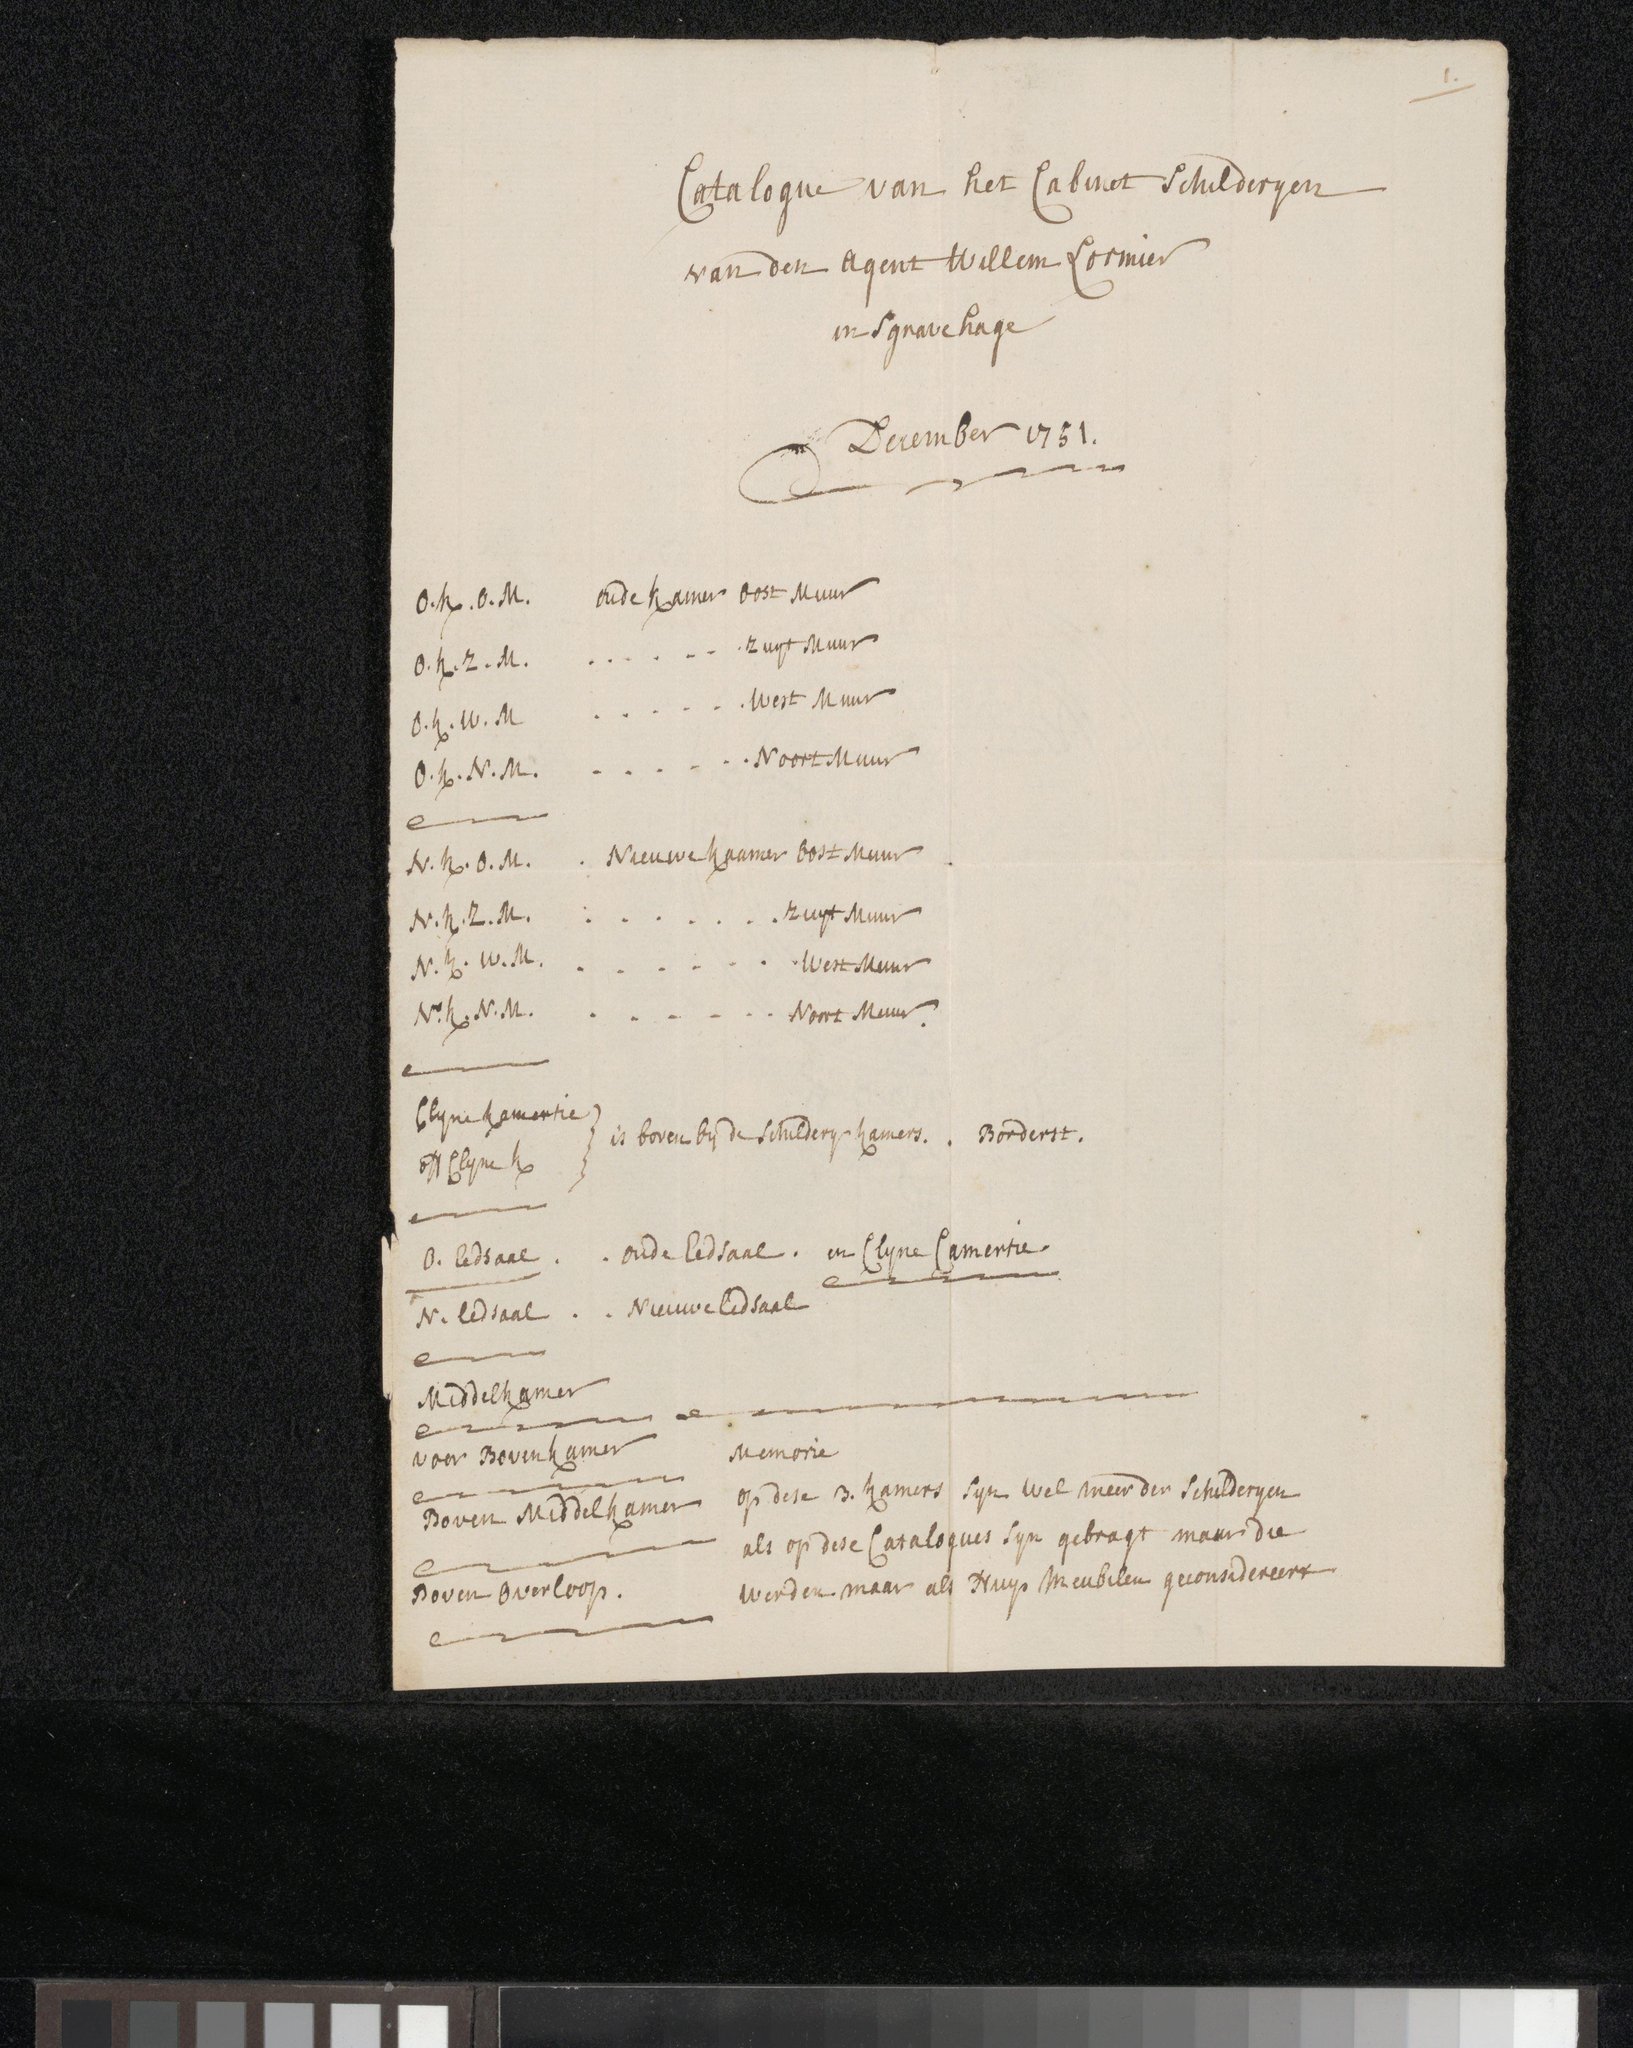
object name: aantekening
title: Aantekening betreffende de schilderijenverzameling van Willem Lormier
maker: Anonymous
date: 1712-1751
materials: ink, paper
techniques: pen, writing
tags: the hague, willem lormier, painting (including book-illumination, miniature-painting), art collecting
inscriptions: watermark